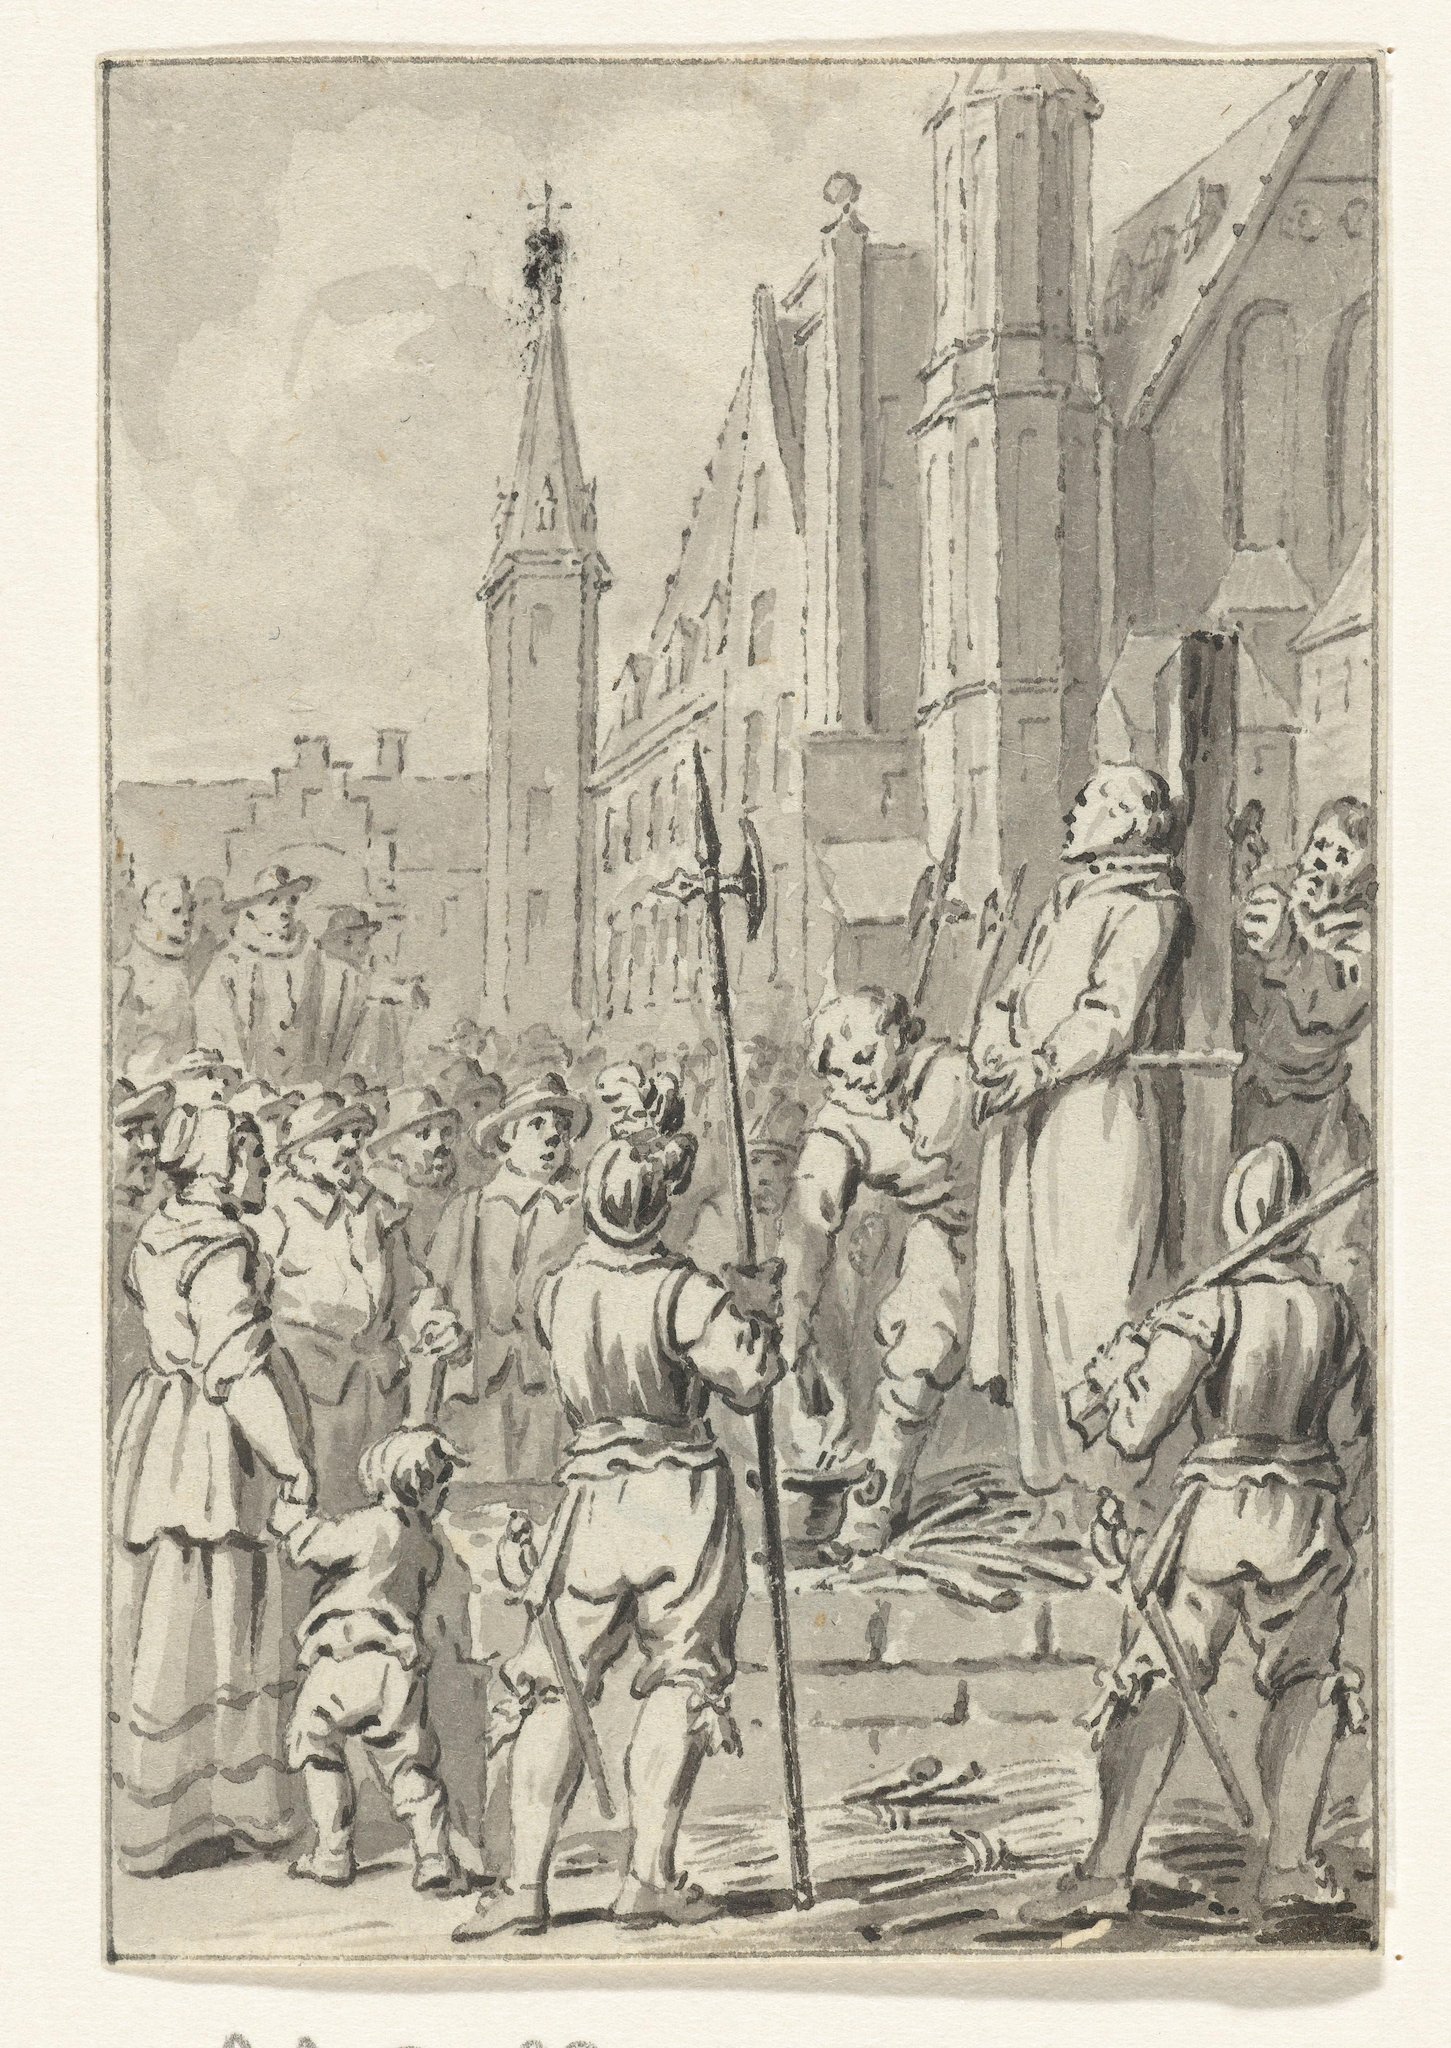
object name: history print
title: Jan de Bakker, priester te Woerden, op het Binnenhof te Den Haag wegens ketterij gewurgd en verbrand, 1525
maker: jacobus buys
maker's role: draughtsman, print maker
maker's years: 1724-1801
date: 1778-1795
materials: ink, paper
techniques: brush, pen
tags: the hague, execution of heretic, e.g. by burning at the stake, 'auto-da-fé', historical persons, death penalty, execution, violent death by burning at the stake; pyre, violent death by strangling, historical events and situations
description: Ontwerptekening voor illustratie in: J. Fokke, Geschiedenissen der Vereenigde Nederlanden voor de vaderlandsche jeugd, Johannes Allart, Amsterdam 1783-1795, 25 delen, dl. III, pl. VI.